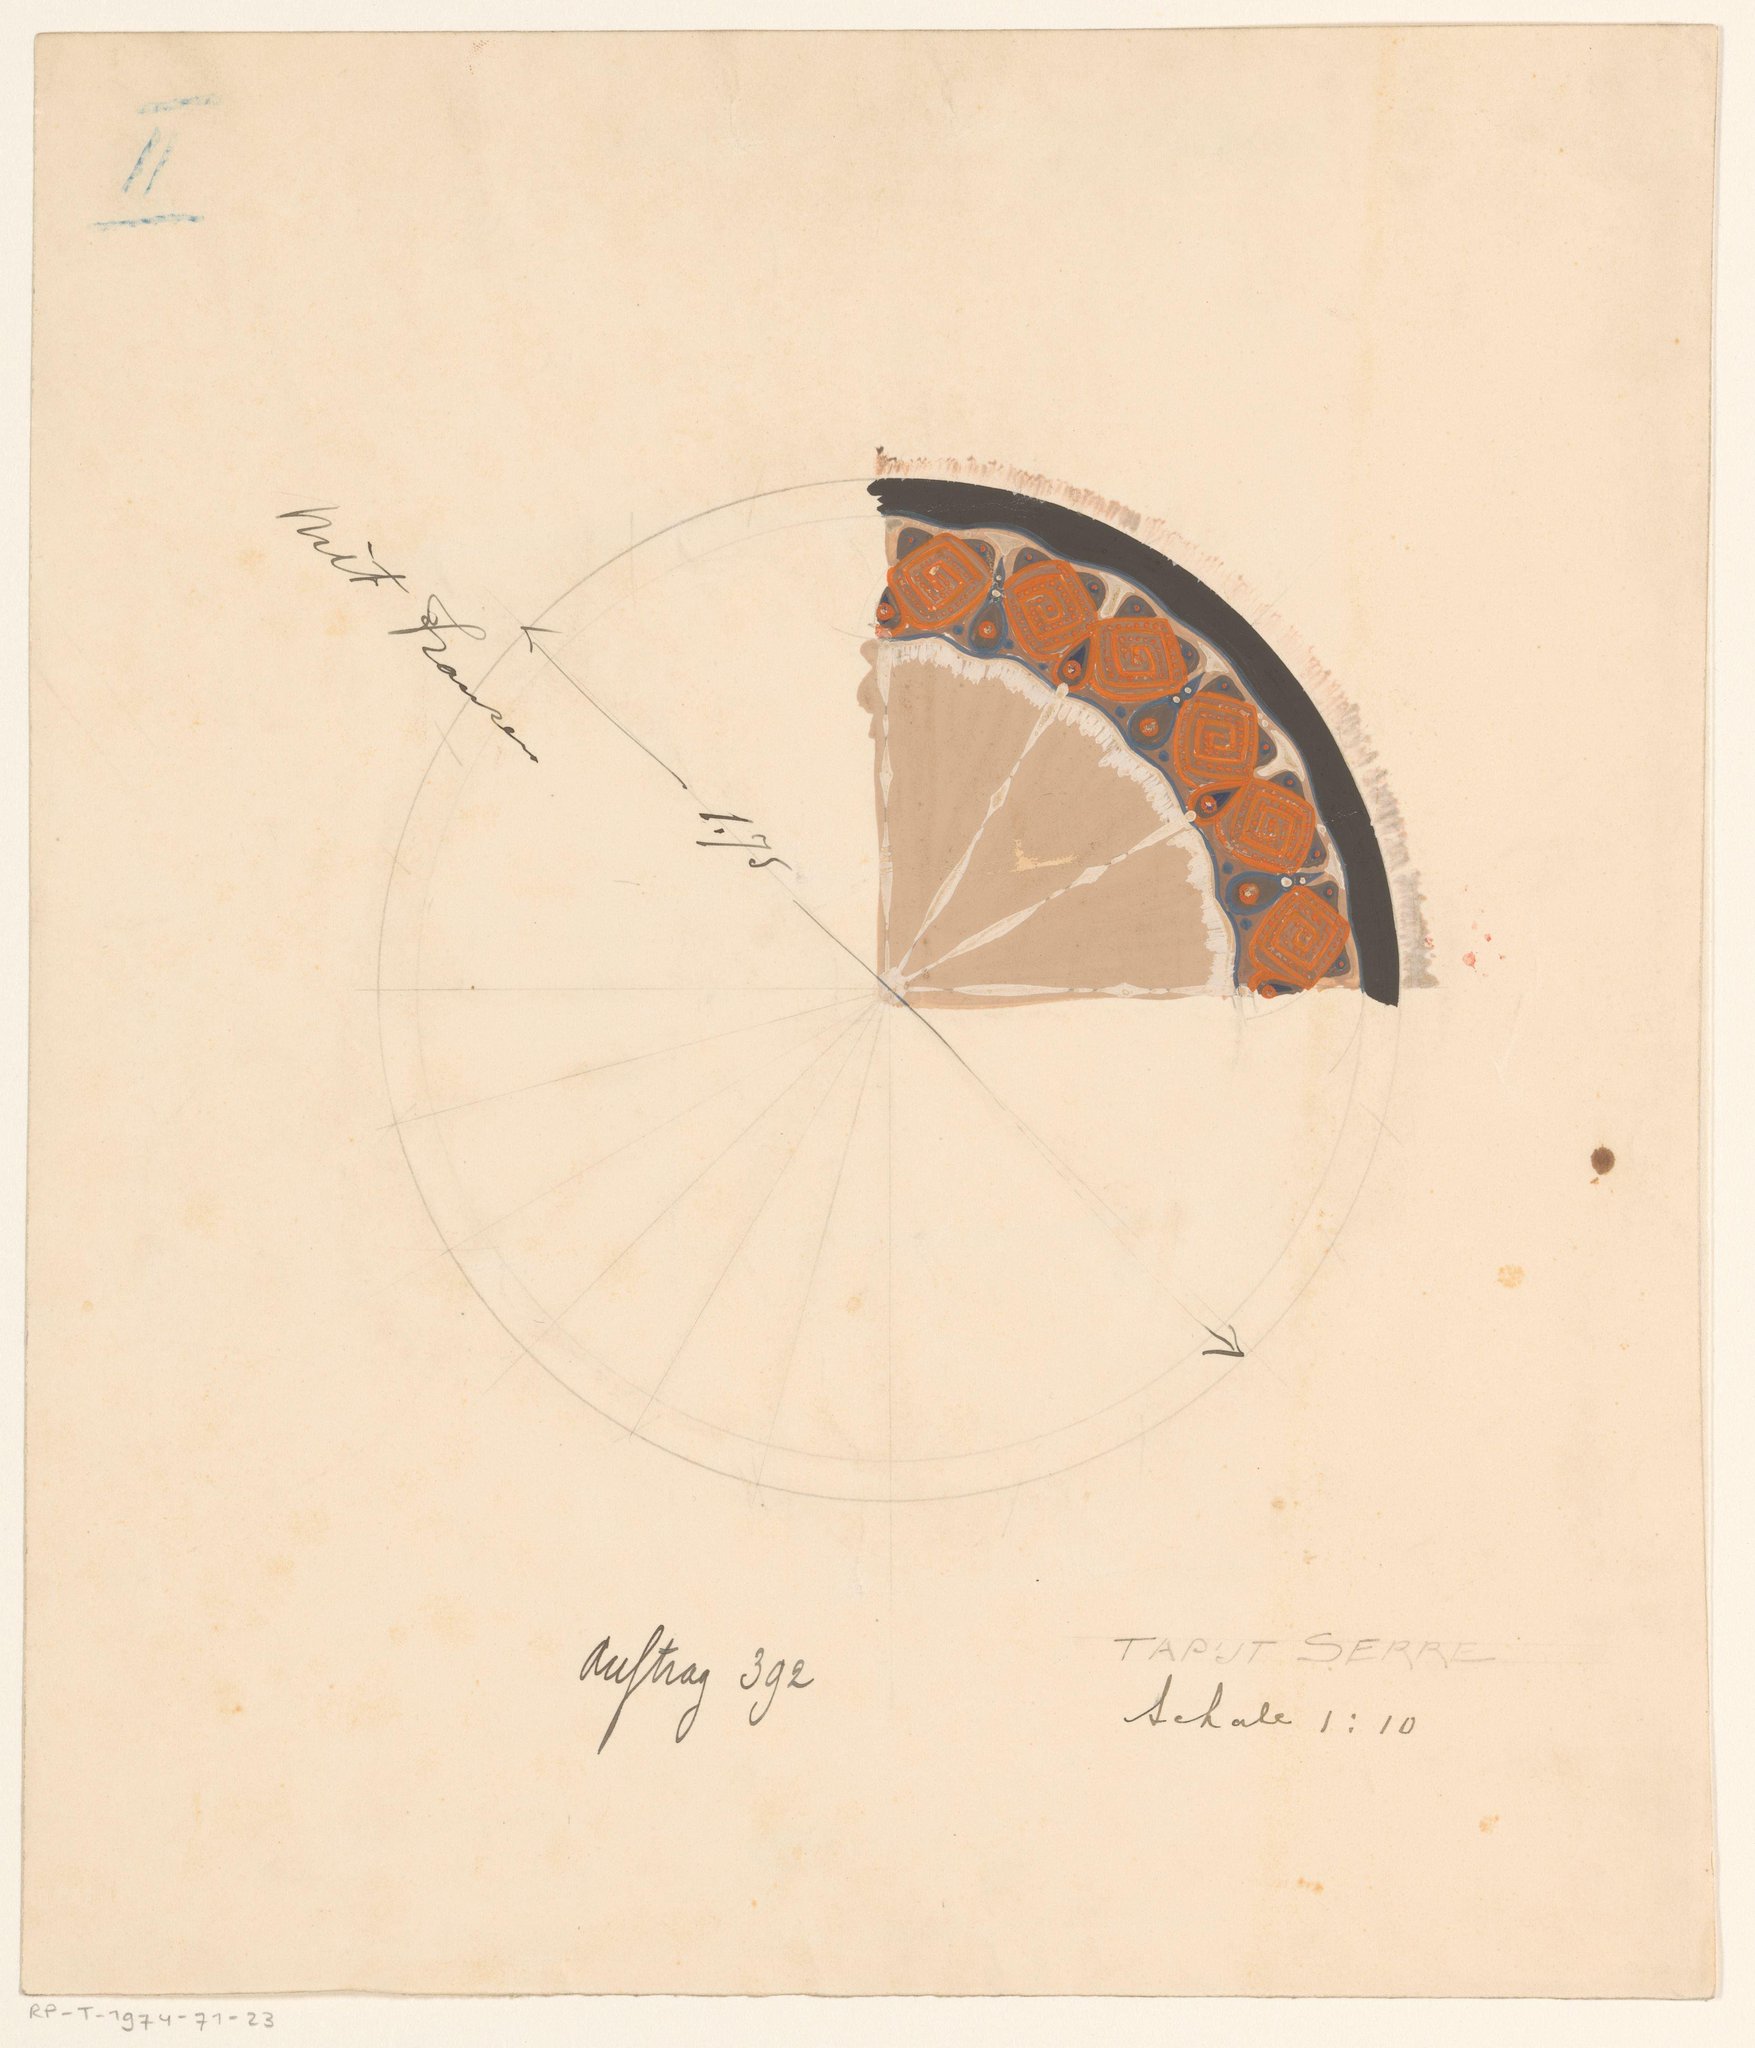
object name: drawing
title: Ontwerp voor een rond tapijt voor een serre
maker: Anonymous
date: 1920-1930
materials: paint, paper, pencil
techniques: brush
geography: amsterdam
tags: ornaments ~ art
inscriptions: number: ‘19.’, annotation, number: ‘II’, collector's mark: ‘R:MVS’, inscription: ‘TAPIJT SERRE/ Schale 1:10’, annotation